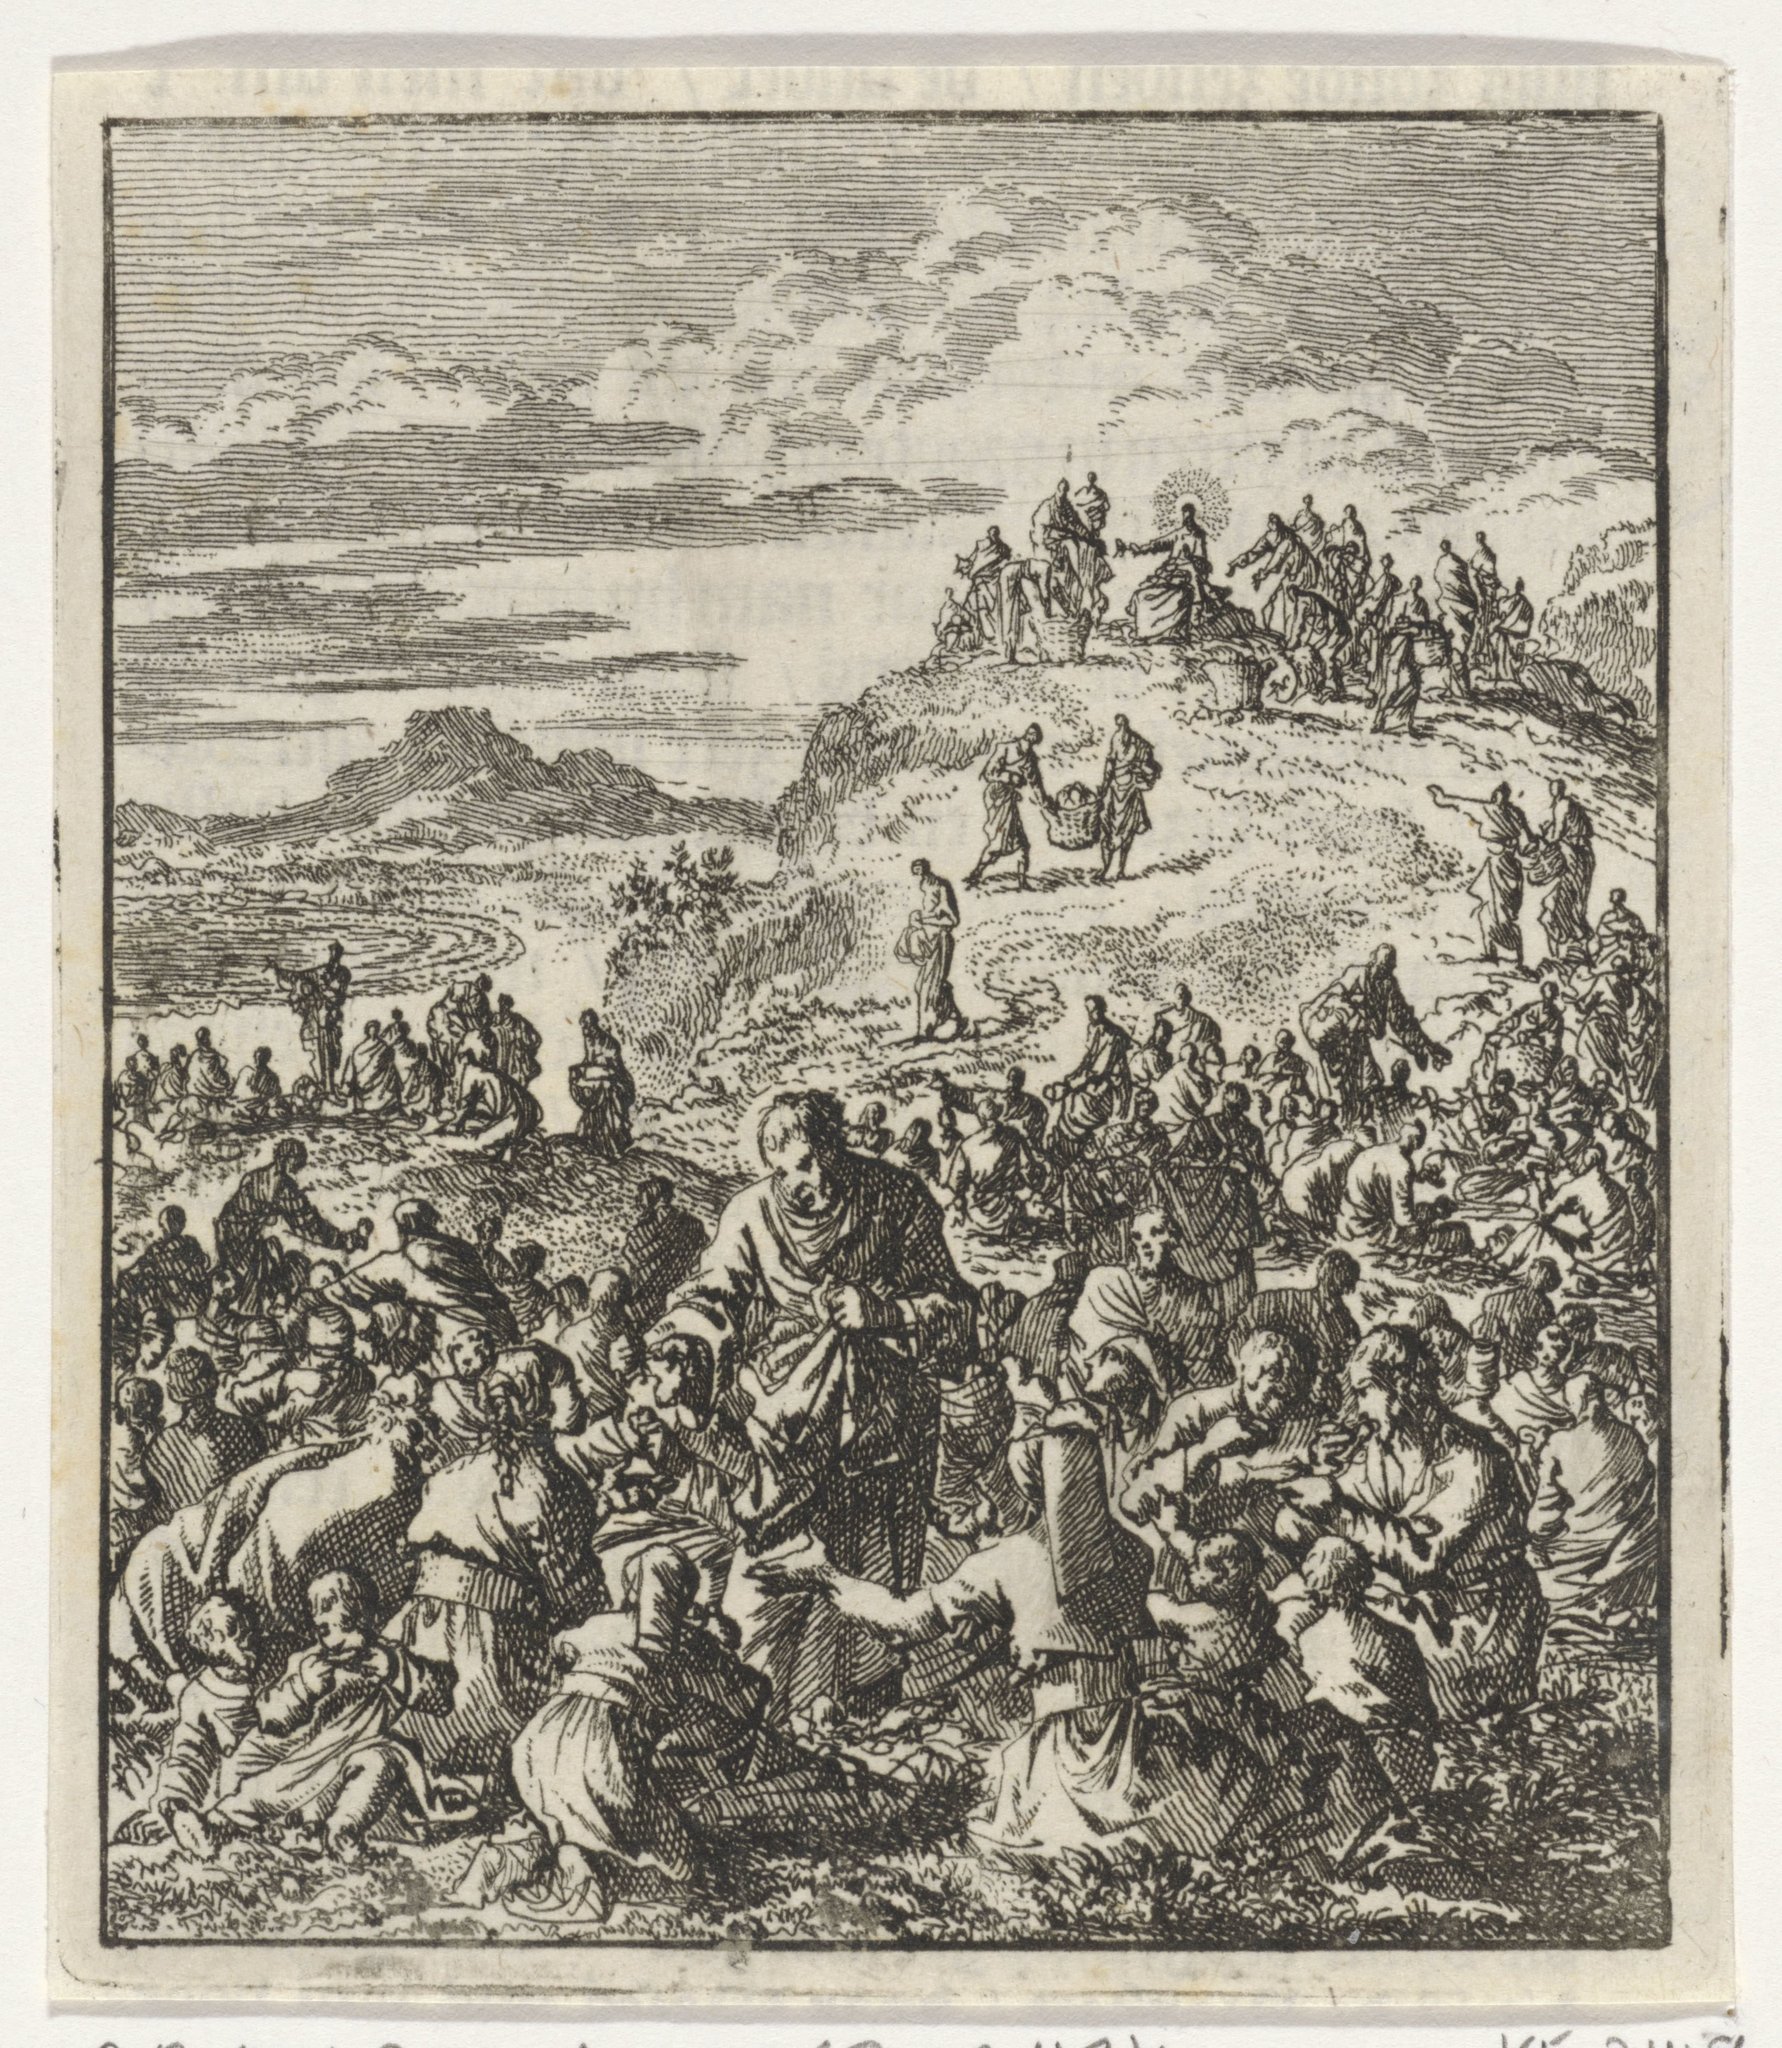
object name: print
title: Apostelen delen brood uit aan de menigte, boven op een berg zit Christus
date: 1706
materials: paper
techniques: etching, letterpress printing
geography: amsterdam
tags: christ and apostles distribute bread and fish among the multitude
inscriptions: collector's mark: Lugt 2228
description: Illustratie voor: Schabaalje, Jean Philipsz. De vermeerderde lust-hof des gemoeds. Amsterdam: Jan Rieuwertsz. (II) en Barent Visscher, 1706, p. 361.